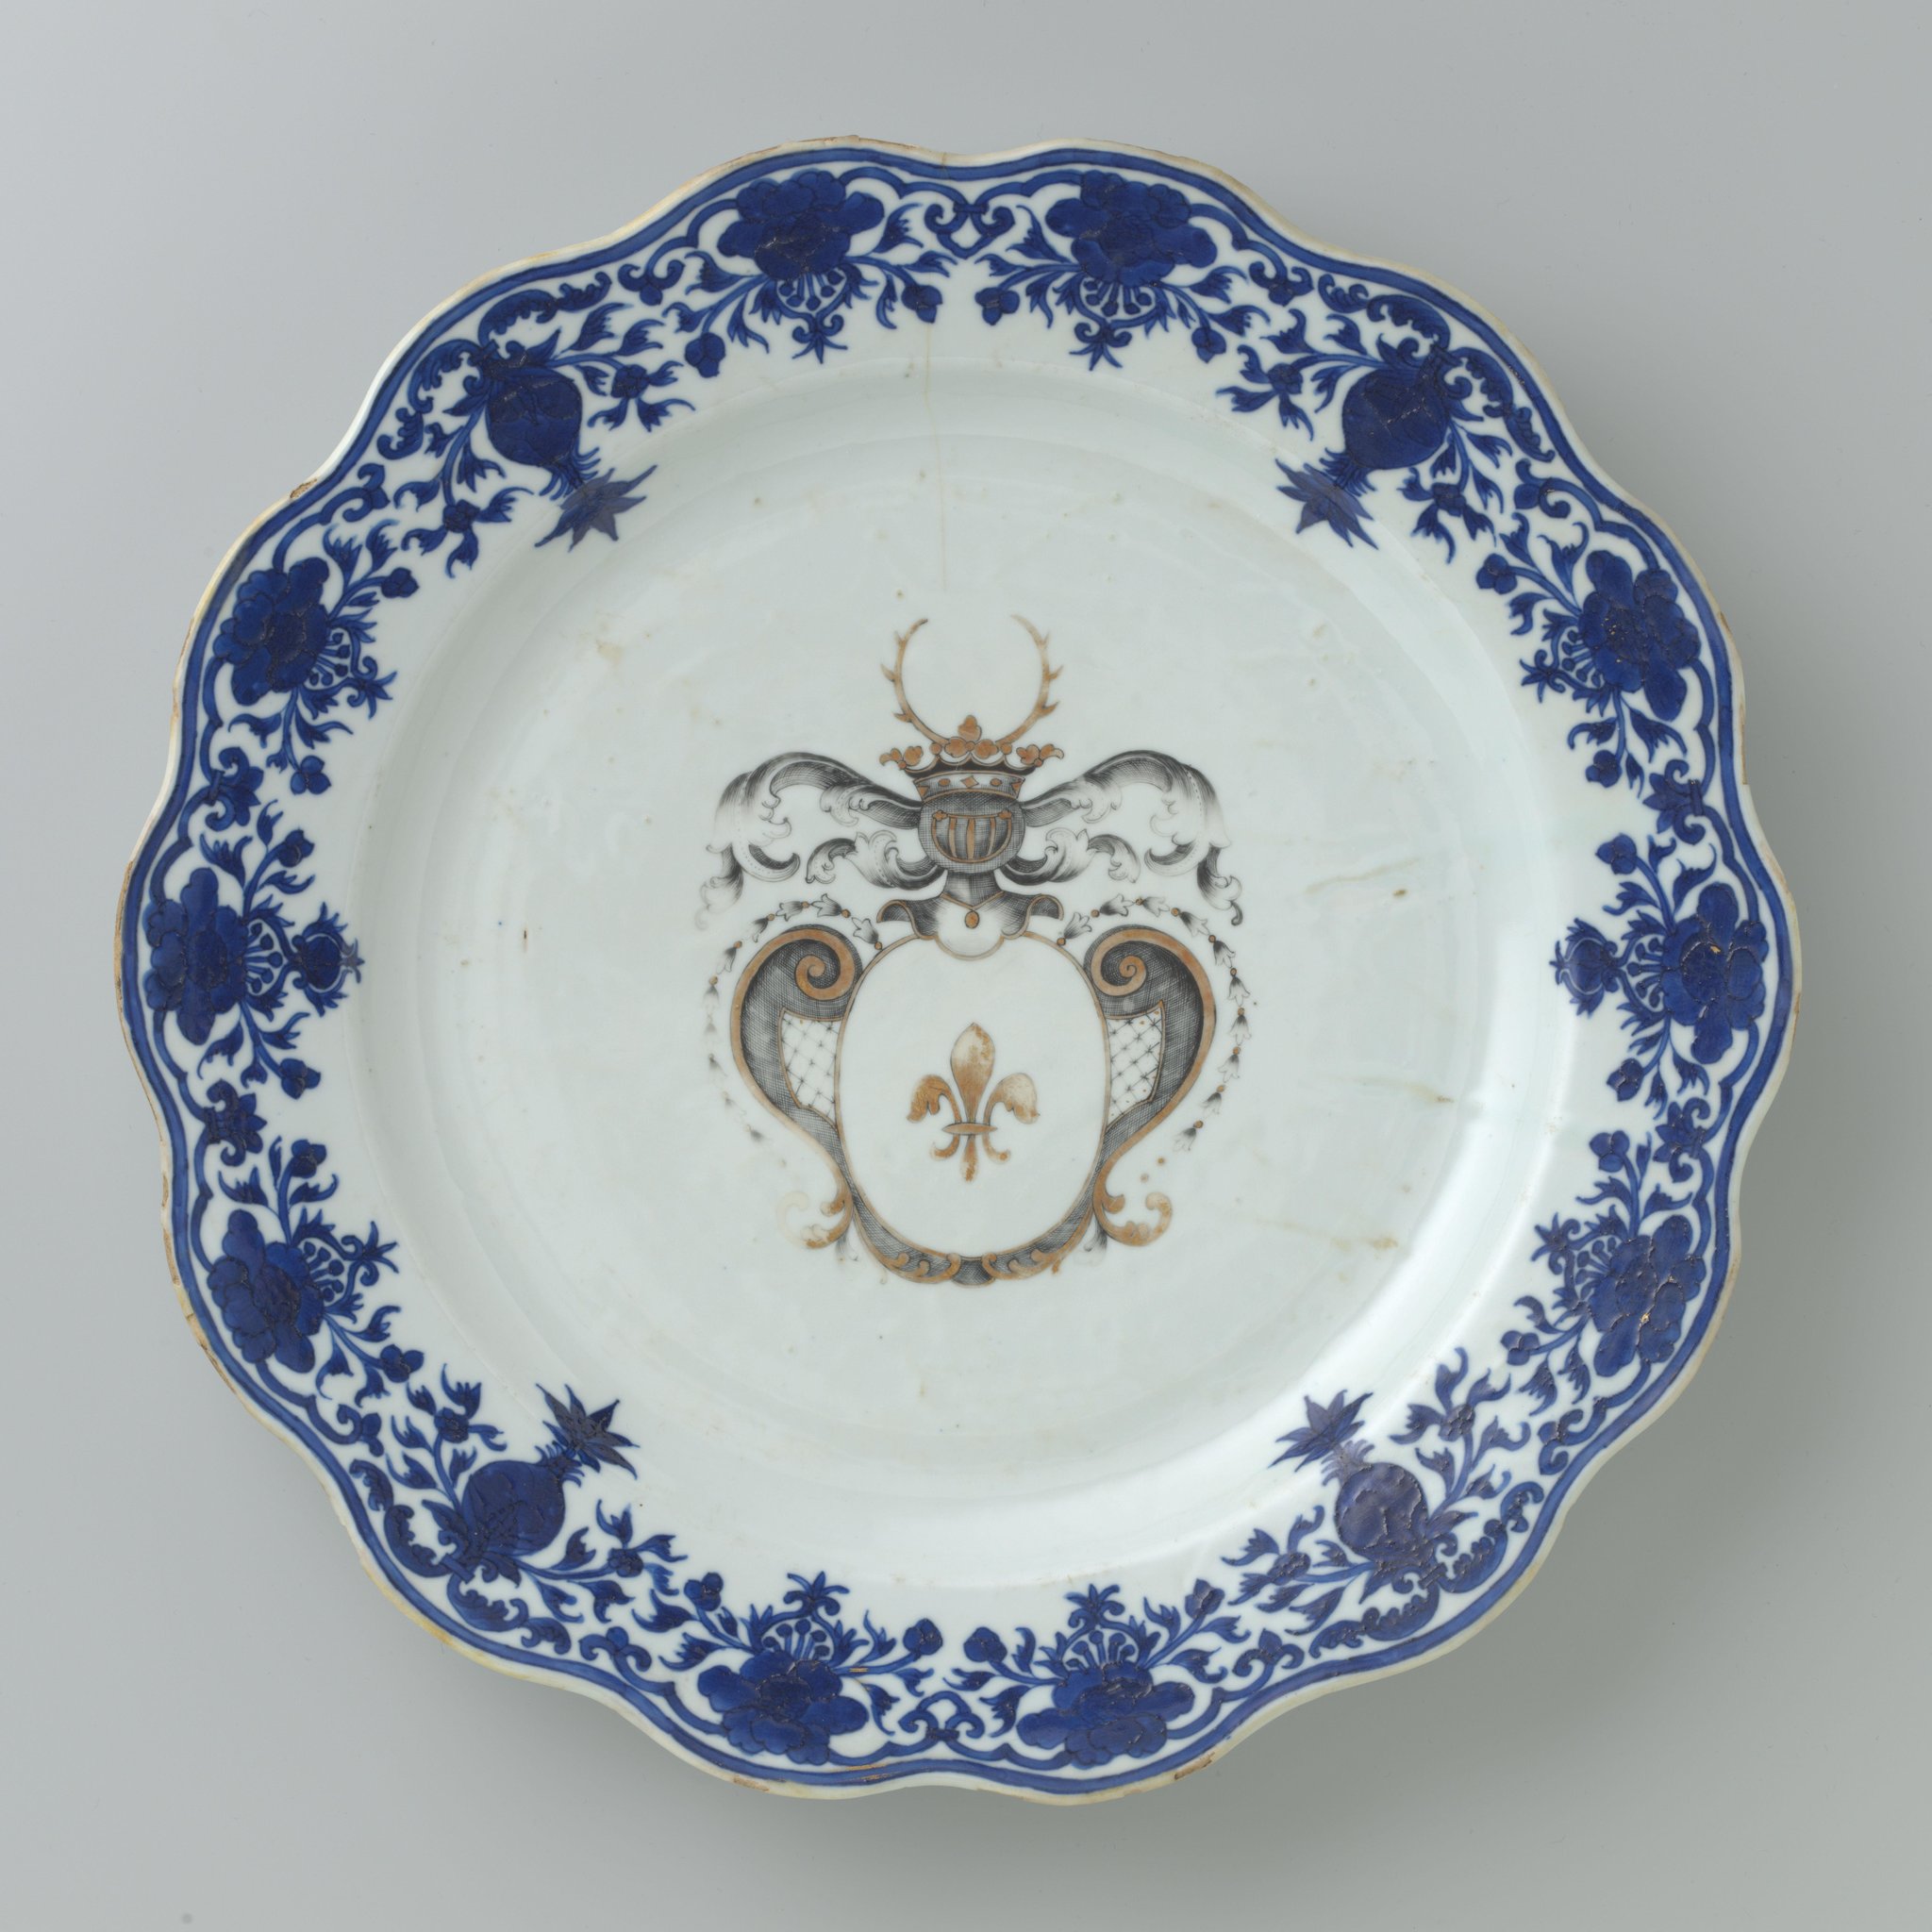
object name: plate dish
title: Bord met het wapen van de familie Swellengrebel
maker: Anonymous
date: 1740-1750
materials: cobalt, glaze, gold, paint, porcelain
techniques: firing, gilding, turning, vitrification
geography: china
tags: utrecht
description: Groot bord op een voetring en met een golvende rand. Beschilderd in onderglazuur blauw en met zwart en goud op het glazuur. Rond de rand een brede band met bandwerk en bloemranken in blauw met goud. In het centrum het wapen van de familie Swellengrebel in zwart en goud: Franse lelie op een ovaal schild en een gewei boven een kroon als helmteken. Wapenporselein in blauw-wit en emailkleuren.